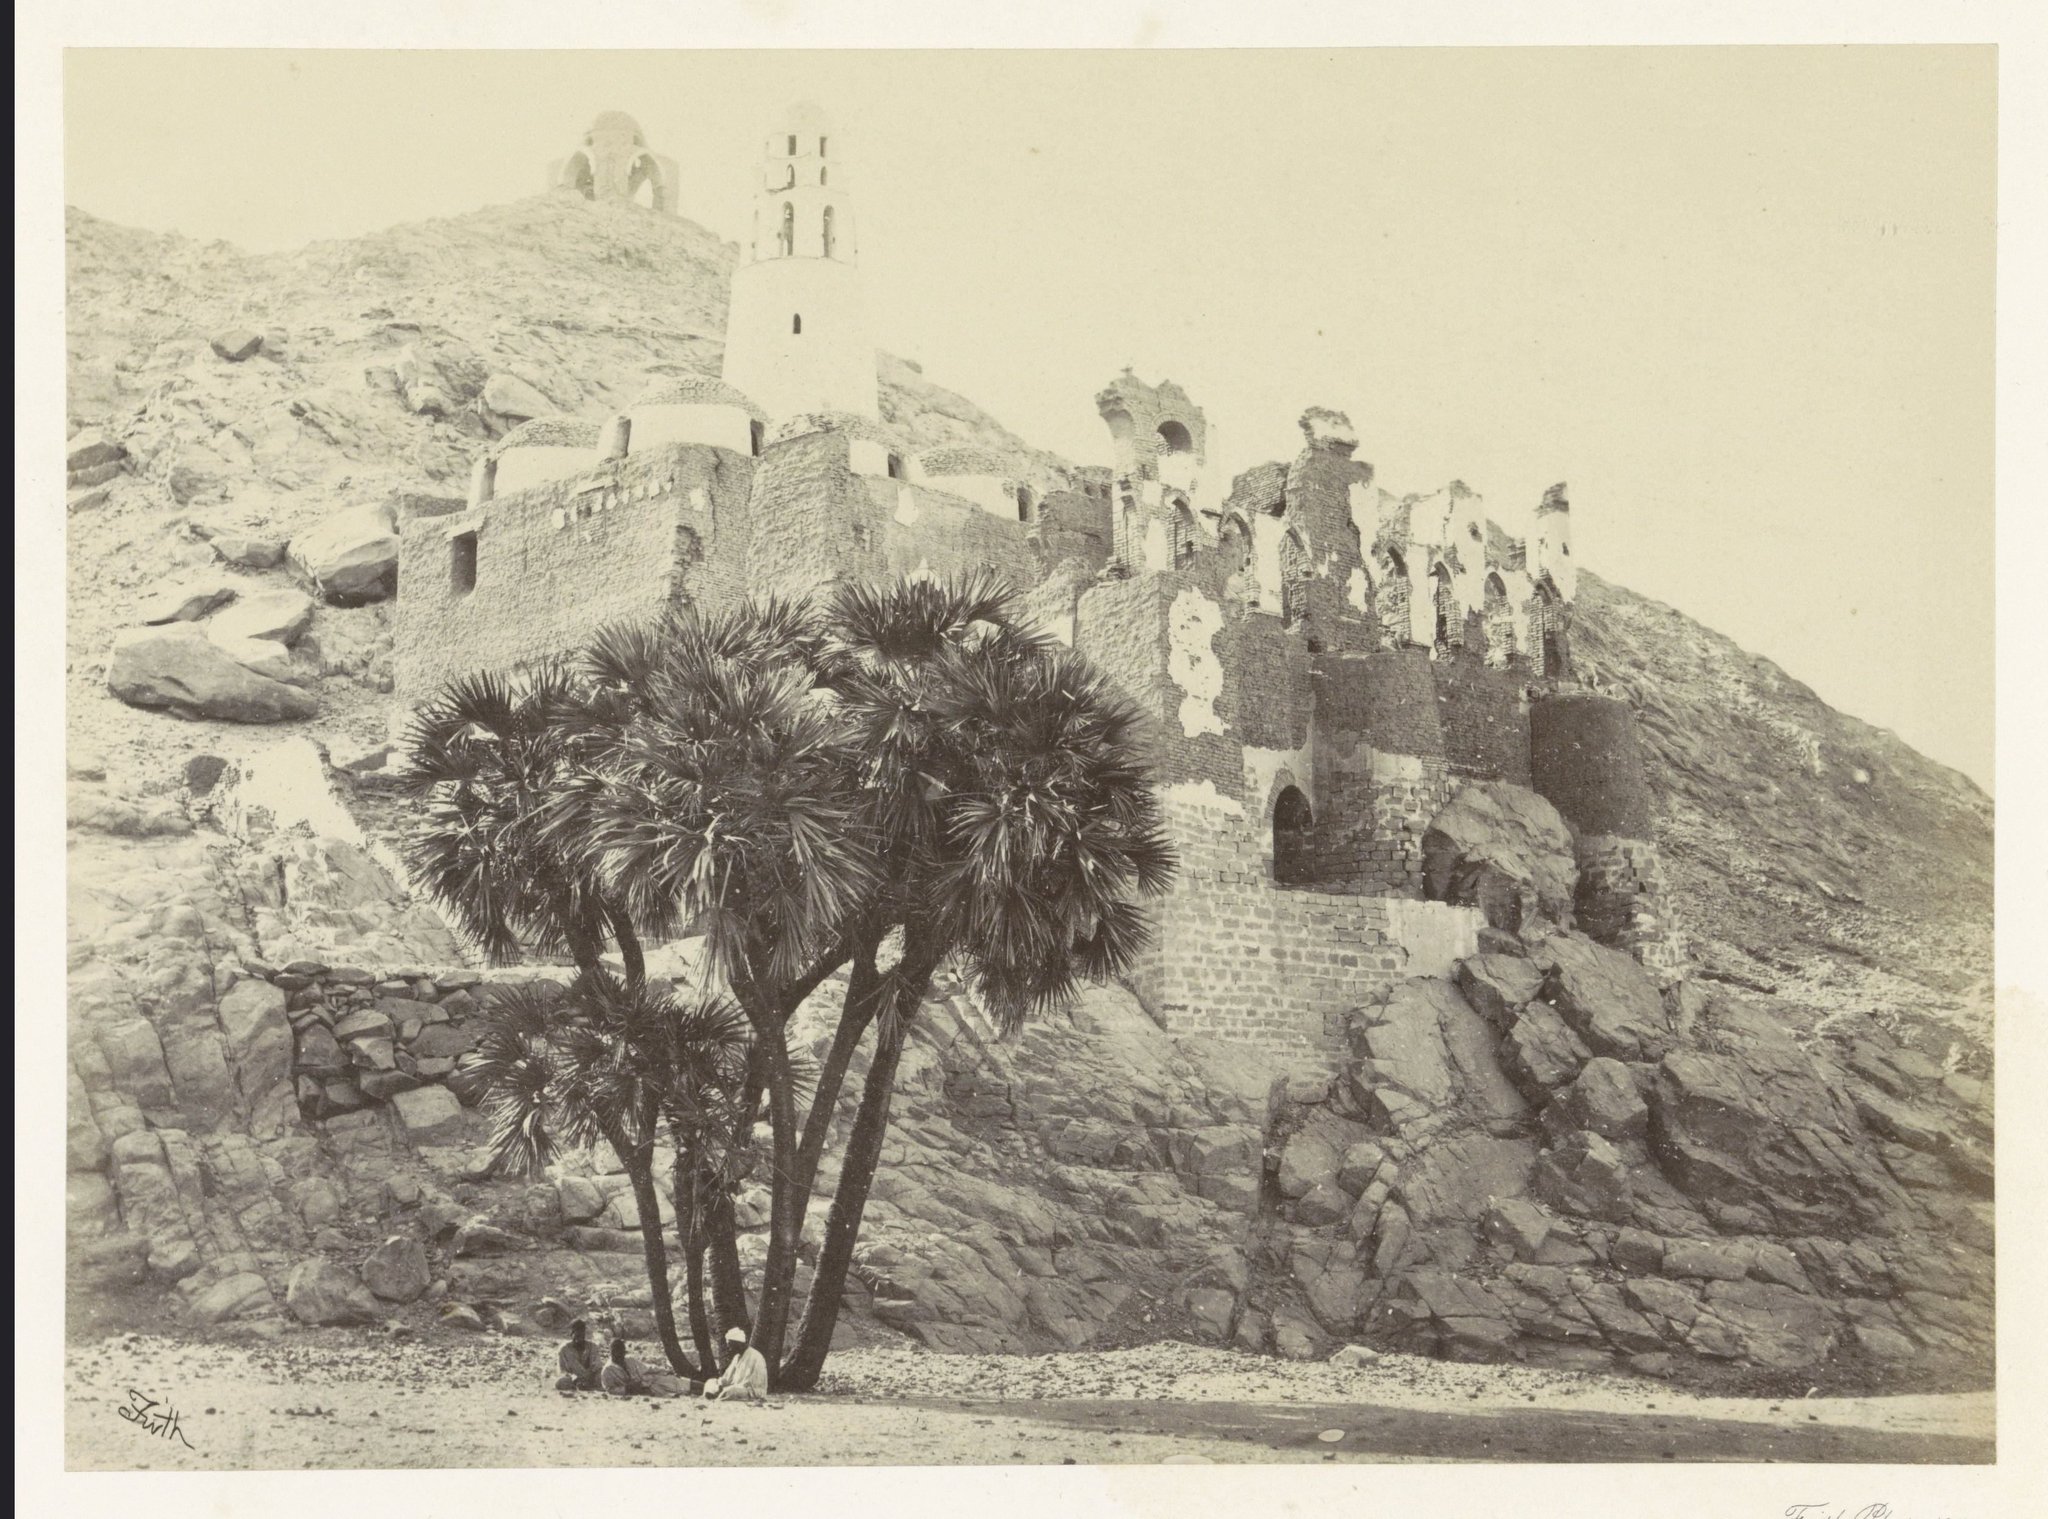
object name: photograph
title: Doum palm, and ruines mosque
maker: francis frith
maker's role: publisher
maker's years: 1822-1898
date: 1857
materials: paper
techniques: albumen print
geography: egypt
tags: ruin of a building ~ architecture, temple, shrine ~ islam, mohammedanism